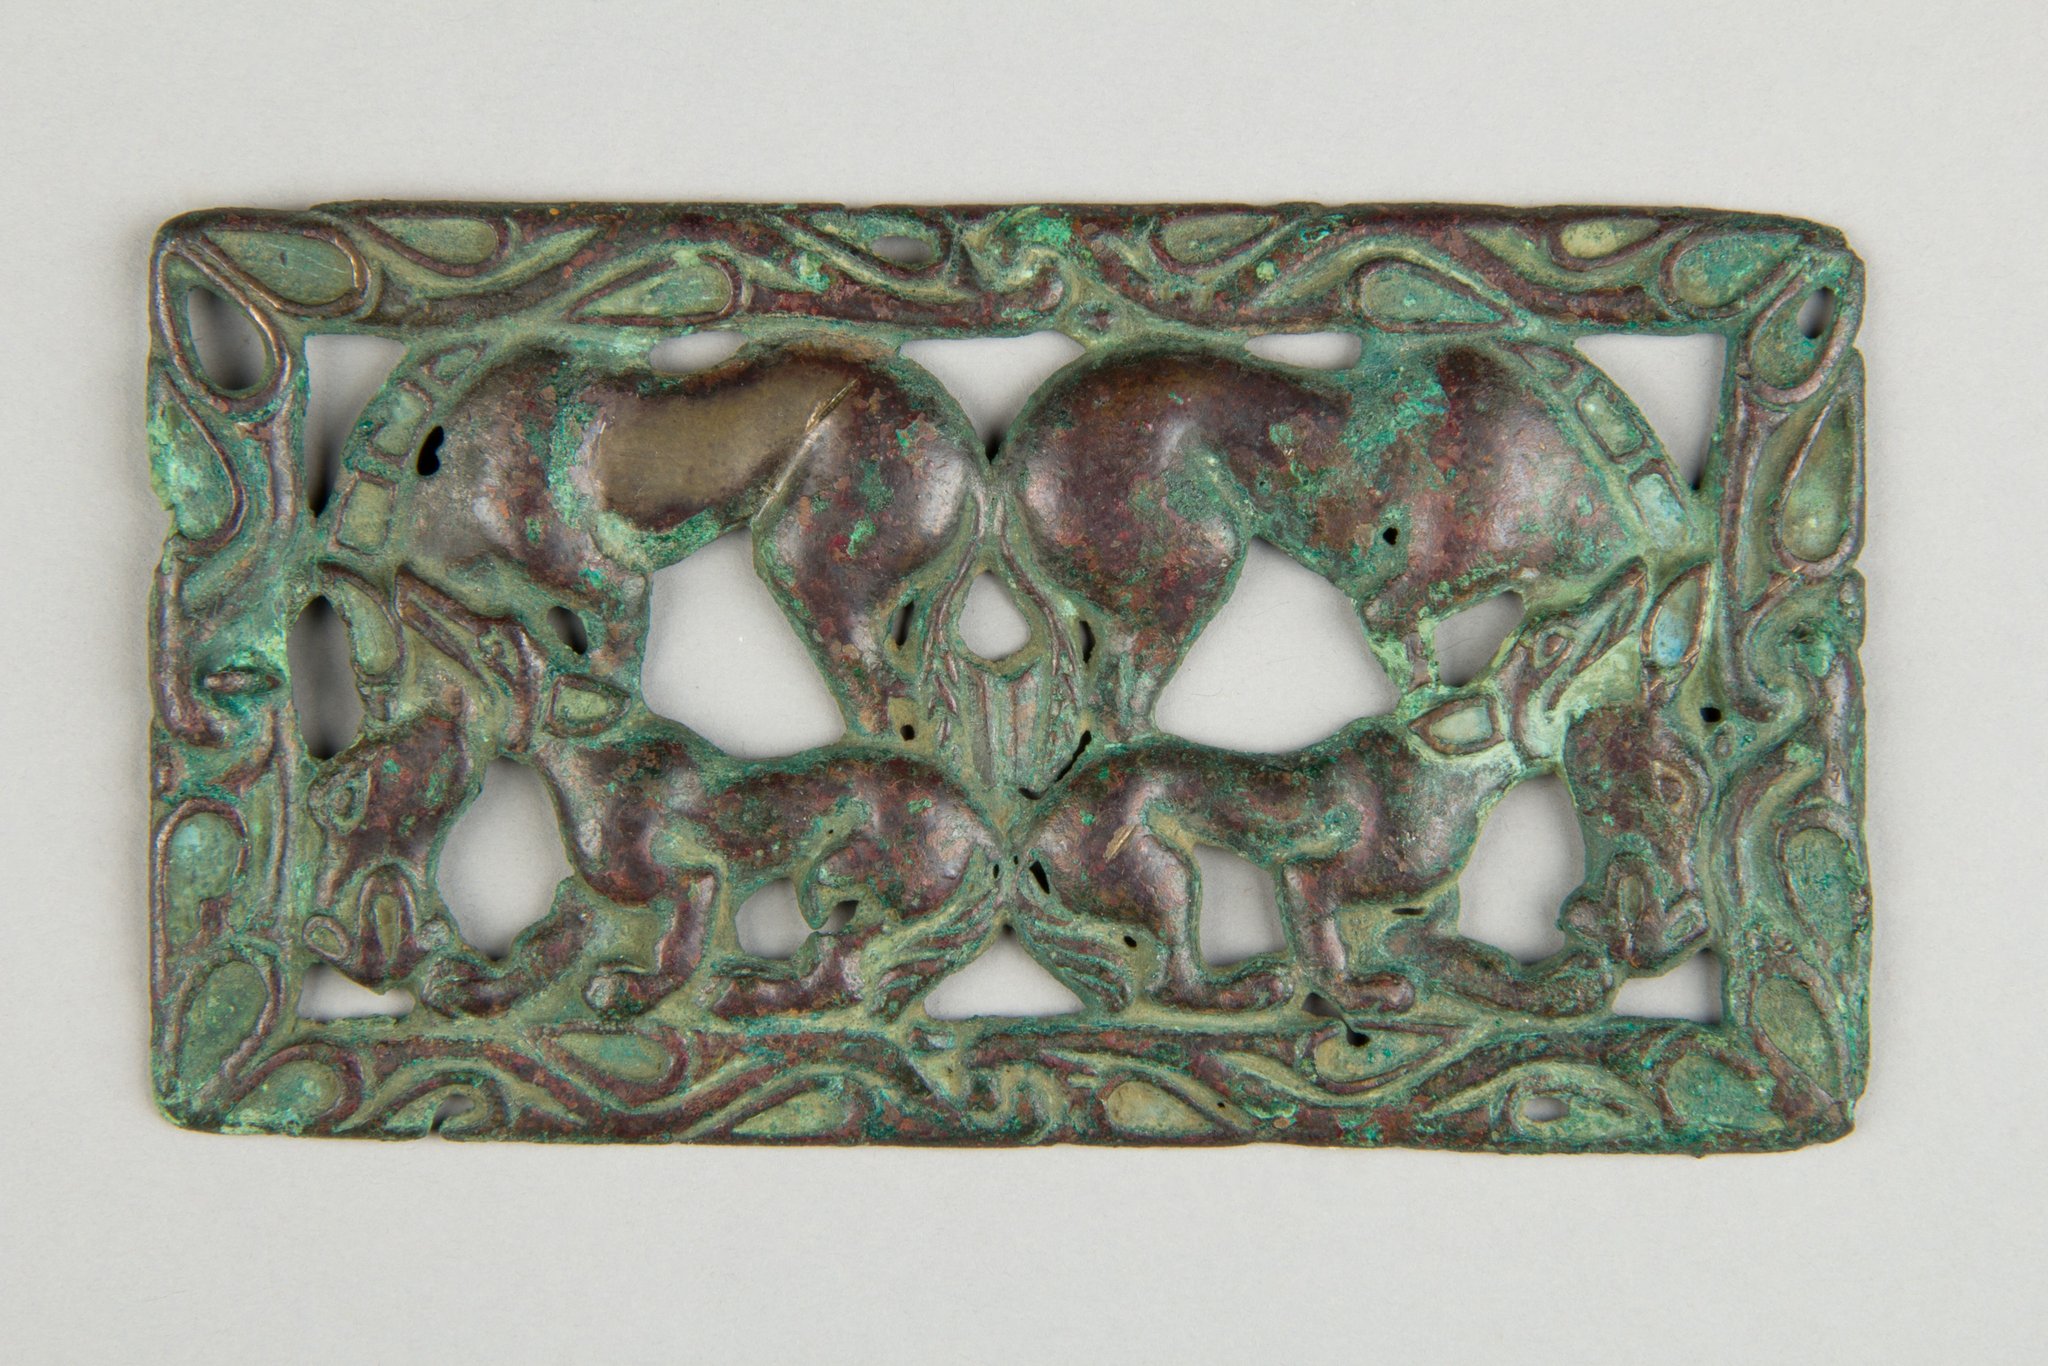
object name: belt buckle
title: Belt Buckle with Kulans Attacked by Wolves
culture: siberian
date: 300-101 BCE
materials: bronze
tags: animals